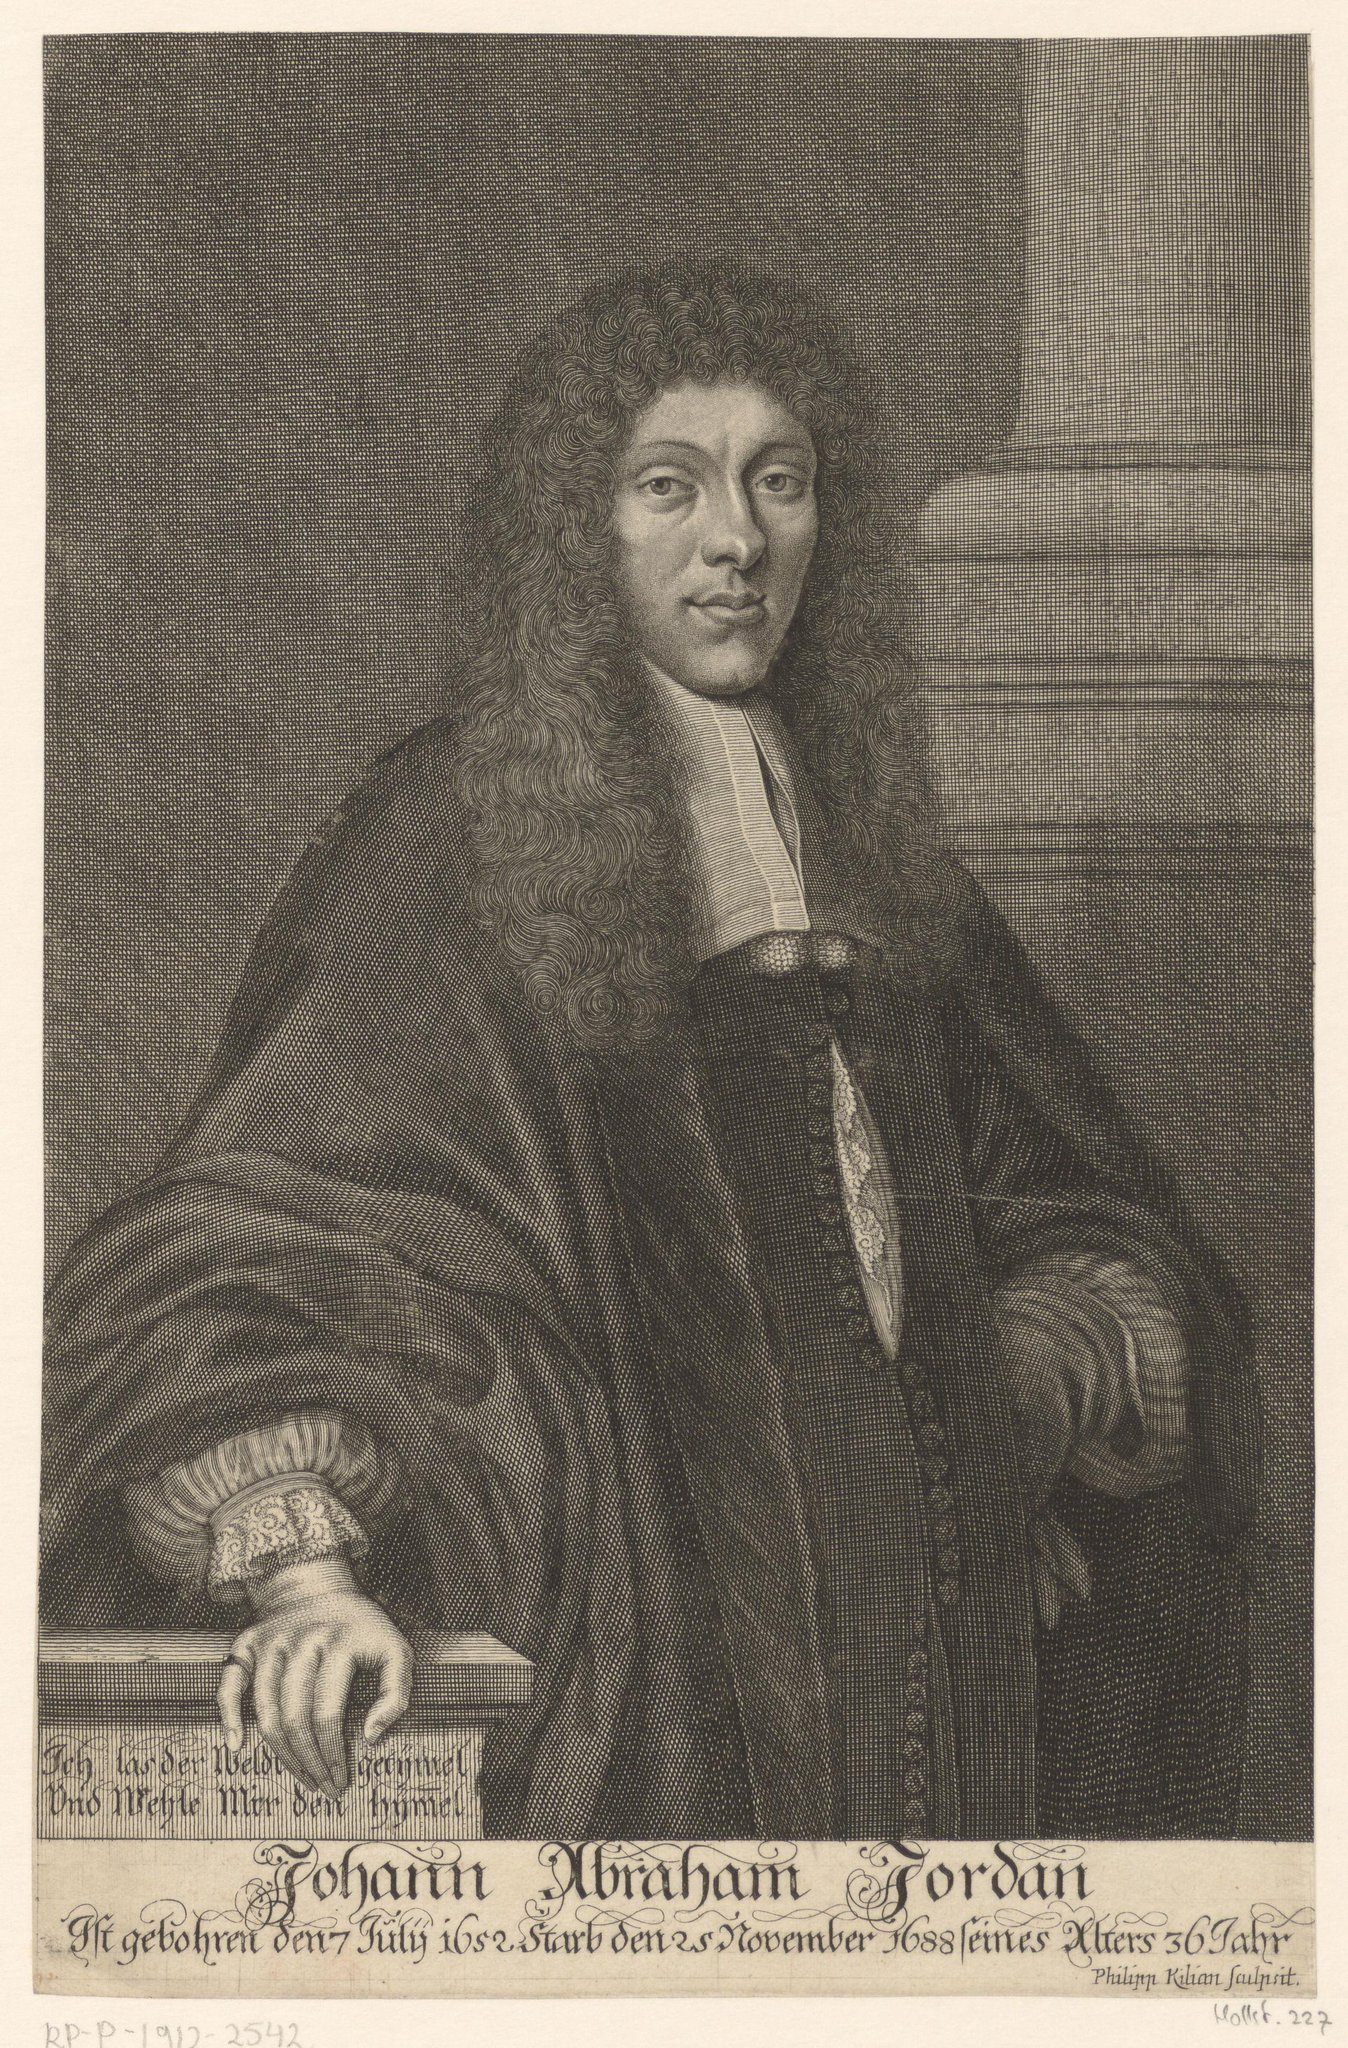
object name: print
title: Portret van Johann Abraham Jordan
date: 1688-1693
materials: paper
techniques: engraving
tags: historical persons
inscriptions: collector's mark: Lugt 2228